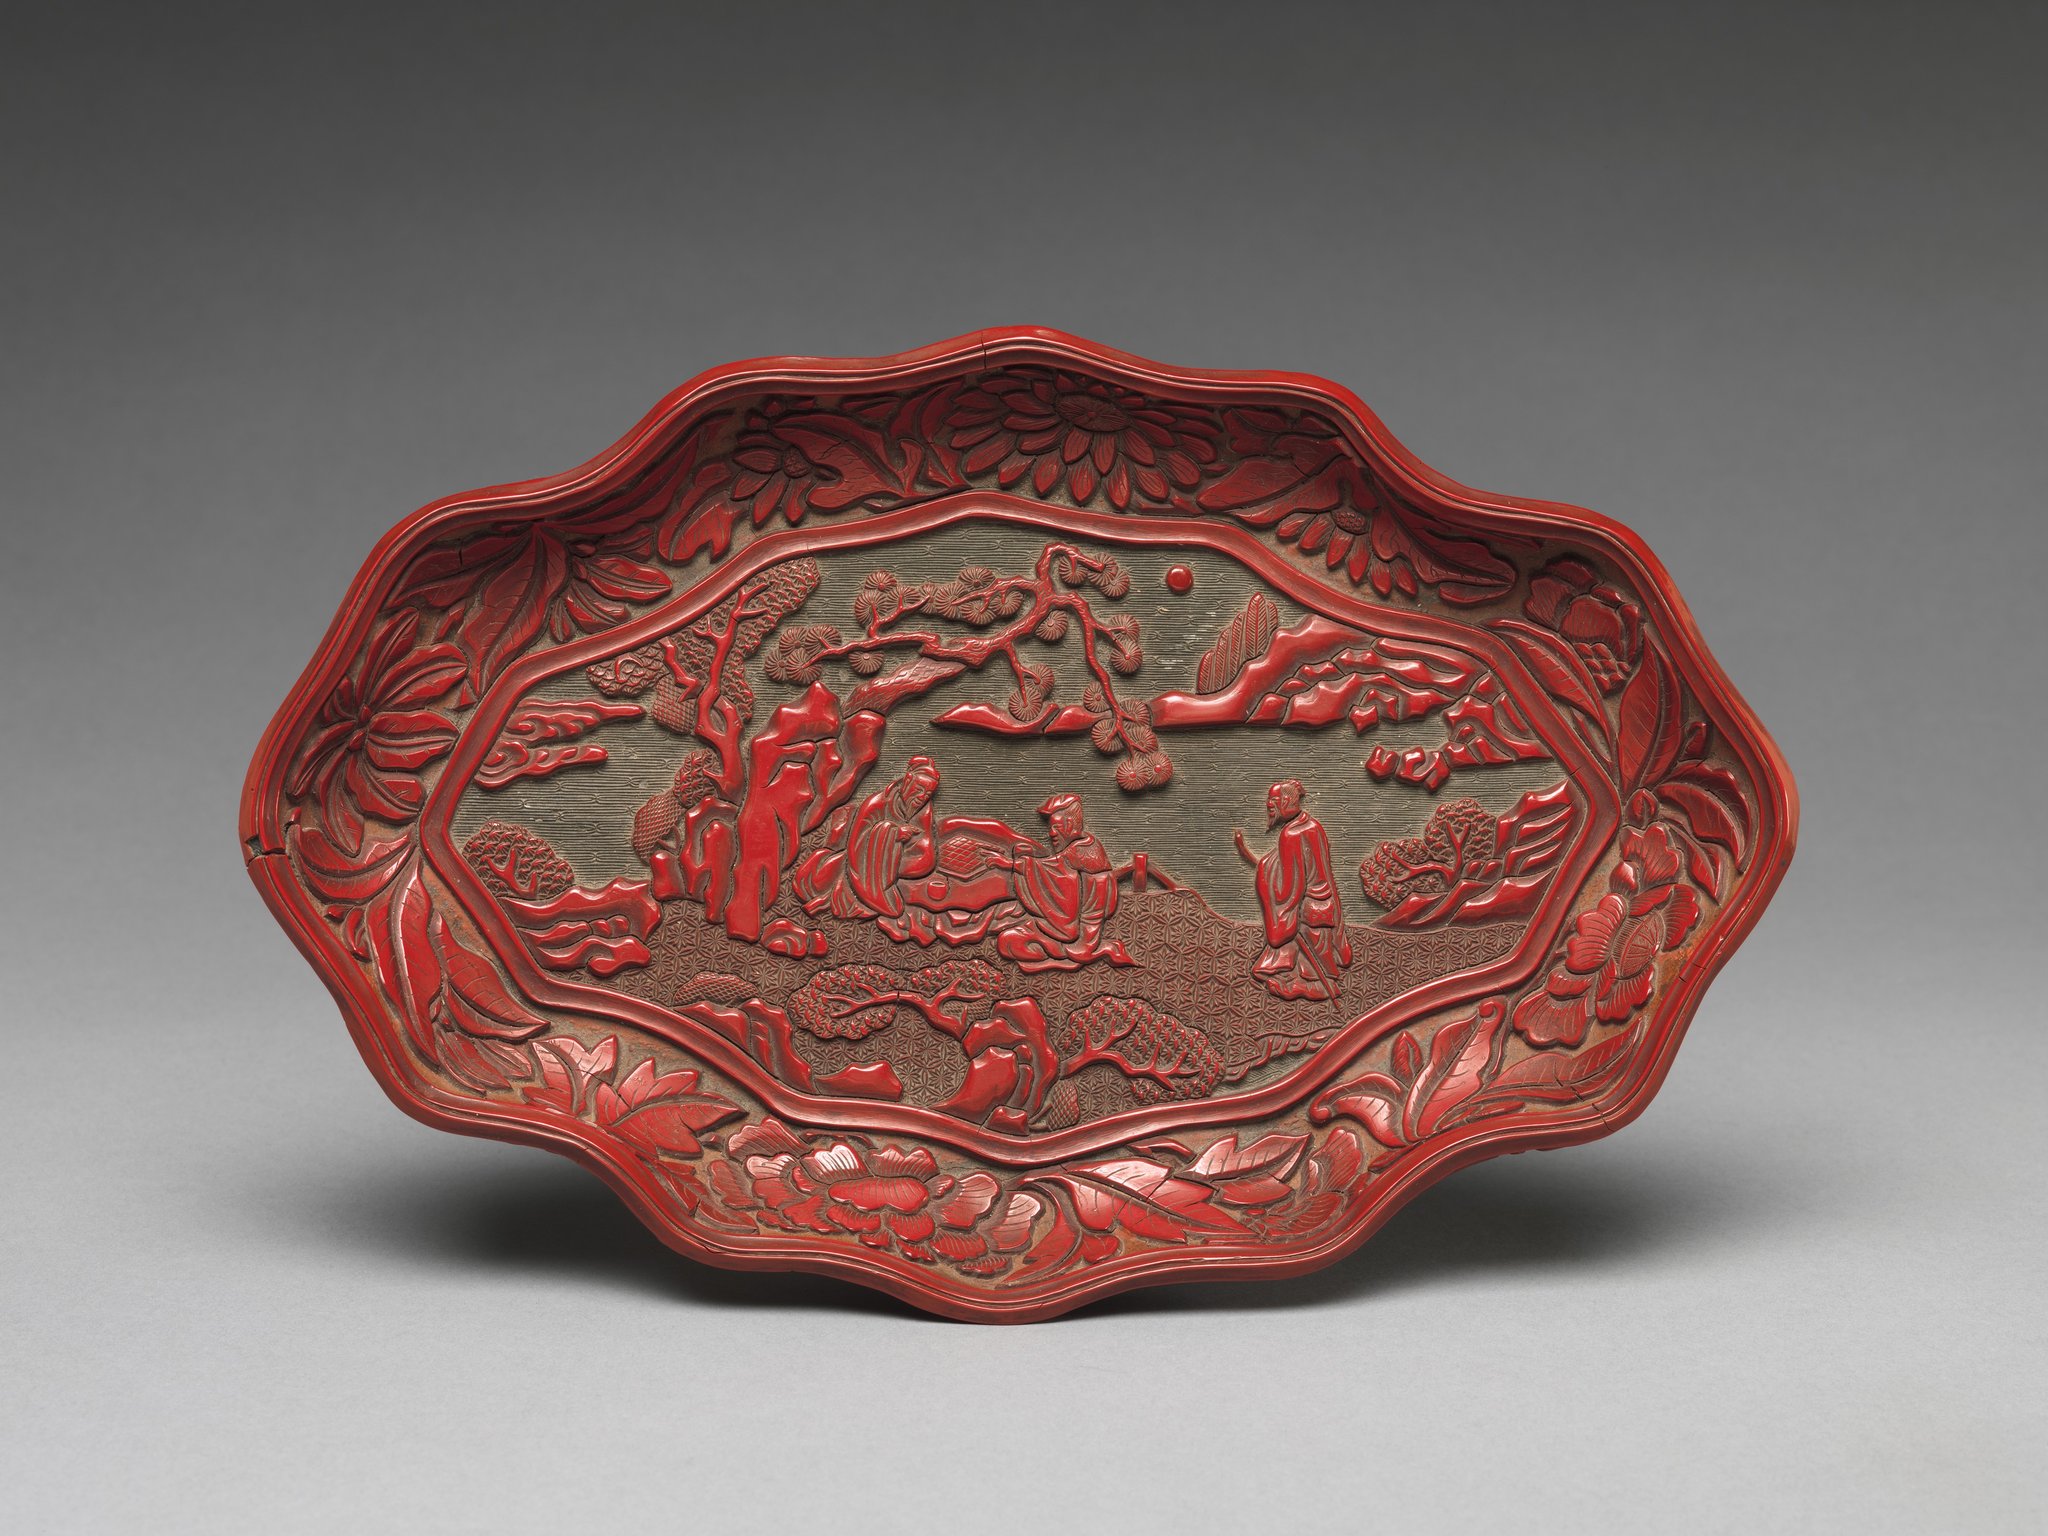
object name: dish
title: Dish with immortals playing weiqi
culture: chinese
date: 1425-1436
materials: lacquer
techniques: carving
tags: flowers,trees